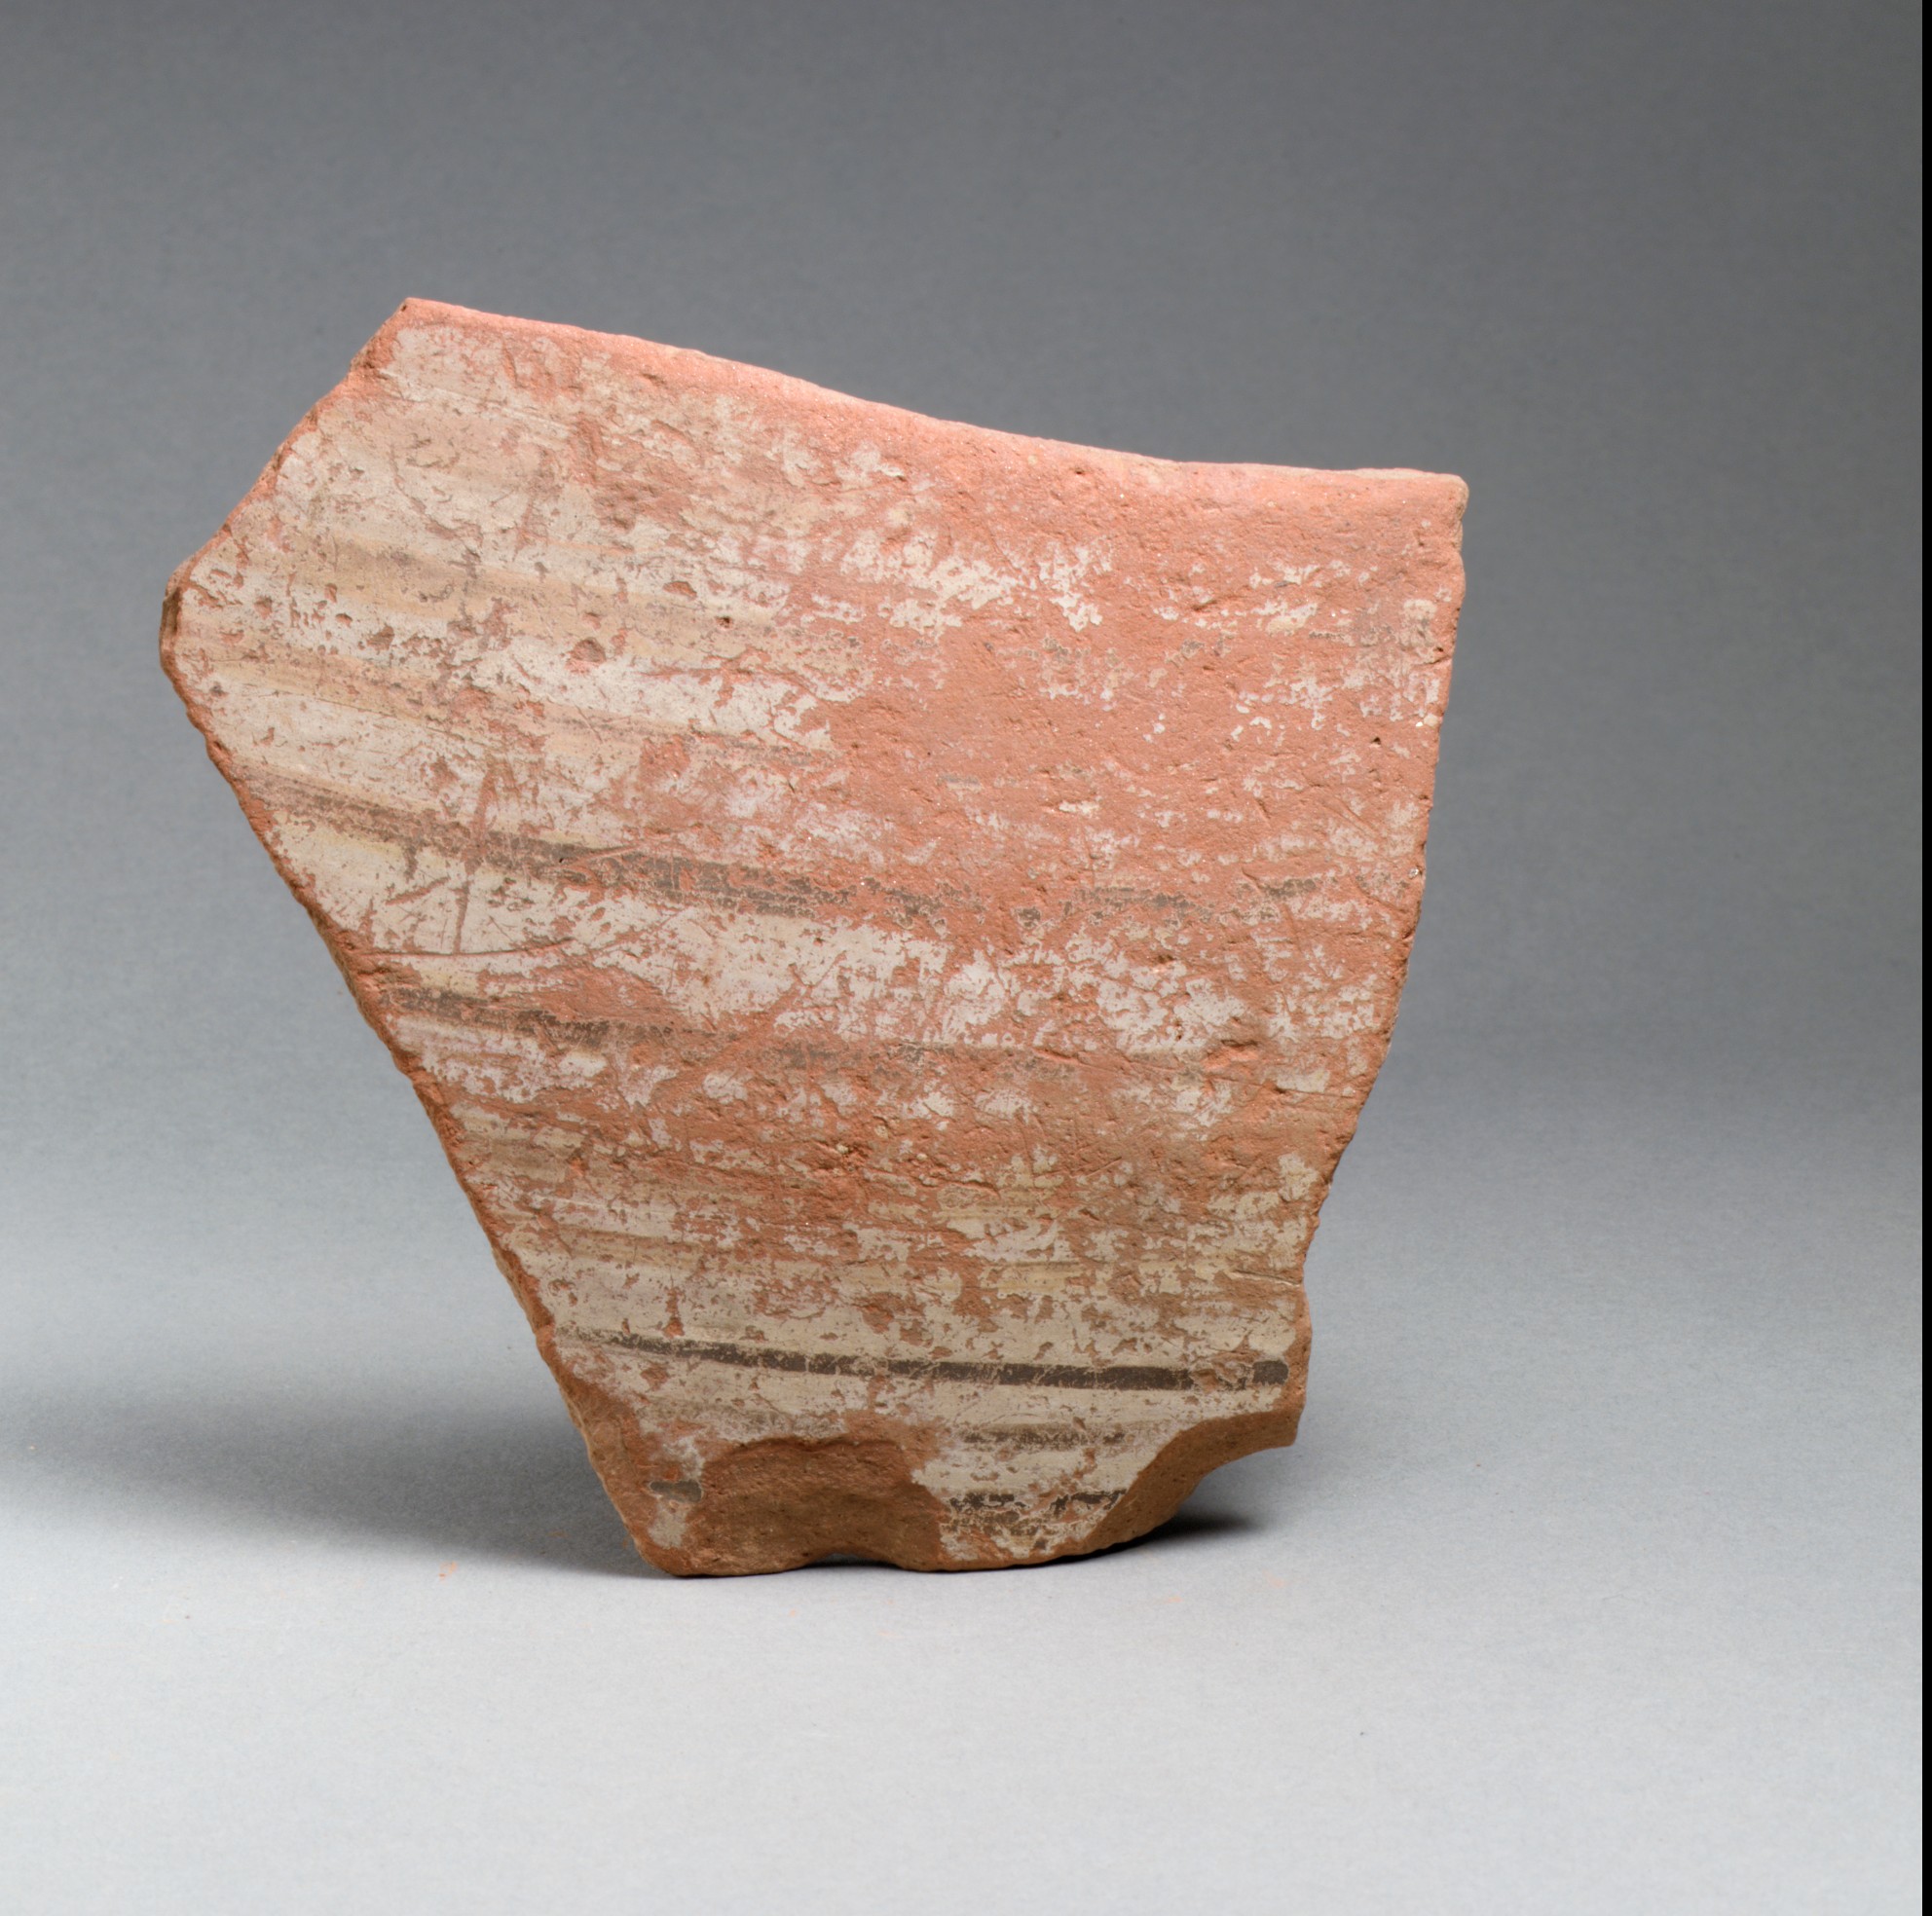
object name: vase fragment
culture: greek or lydian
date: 900-30 BCE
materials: terracotta